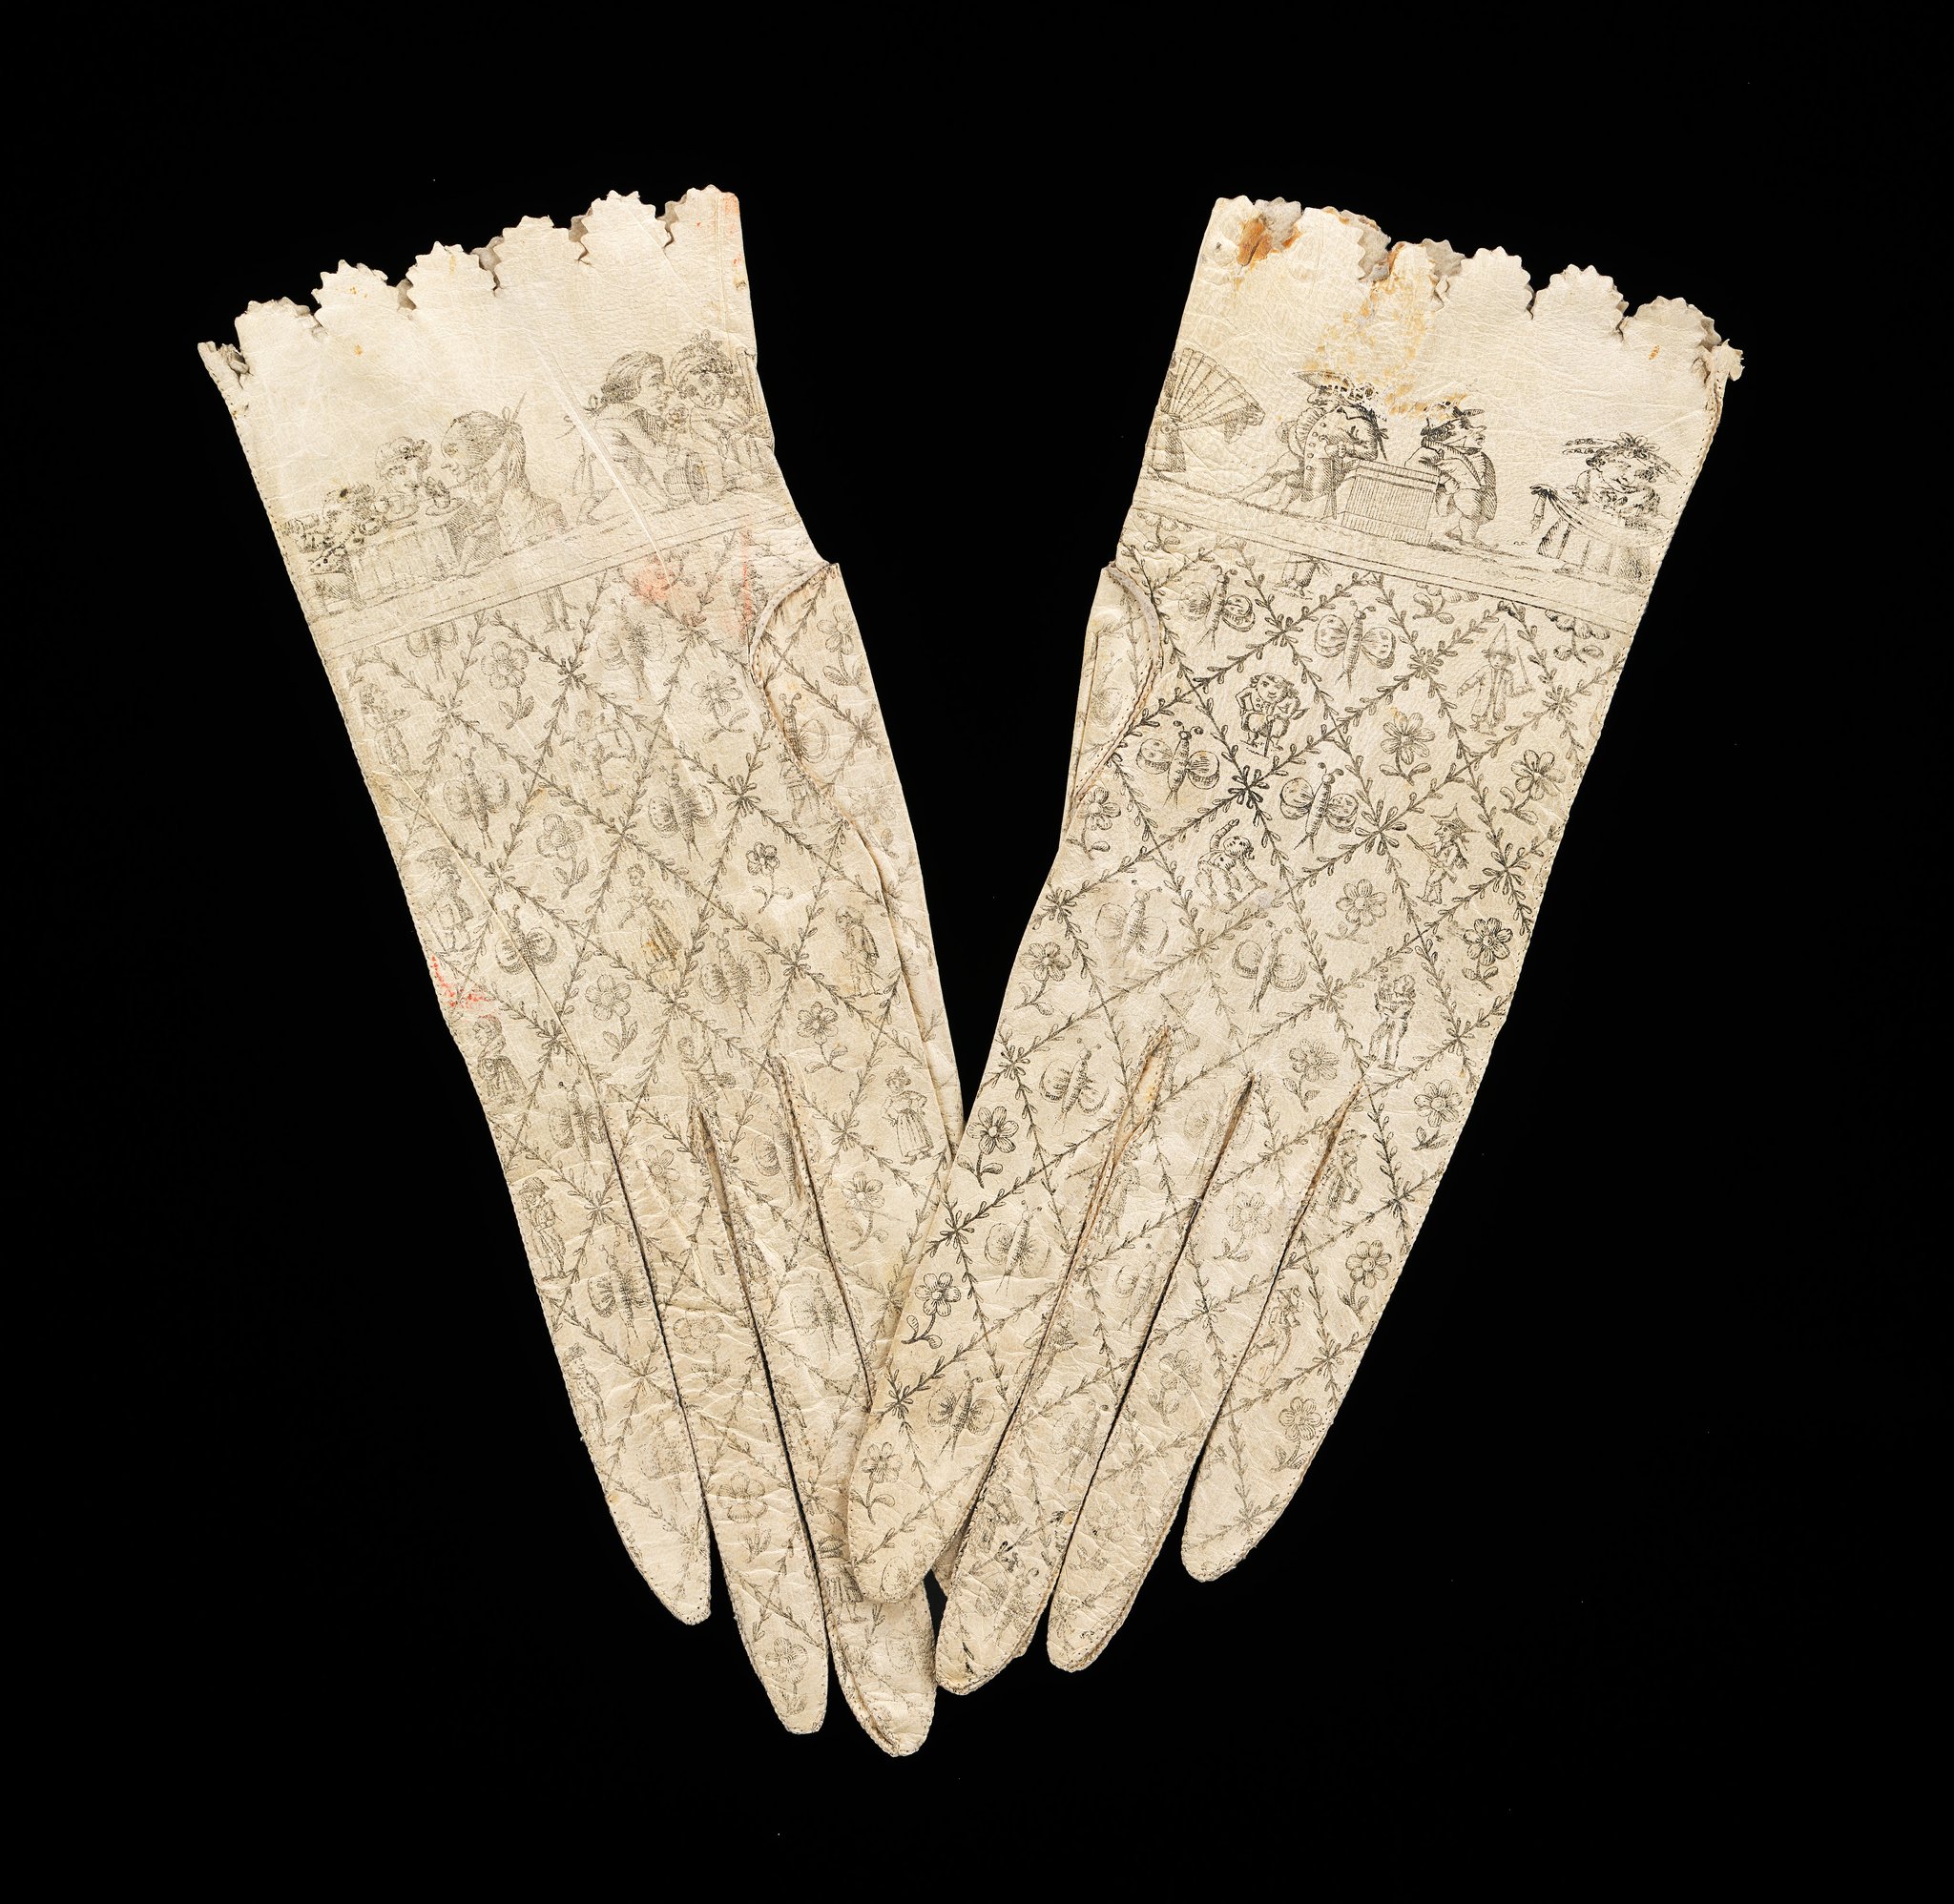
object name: glove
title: Gloves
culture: spanish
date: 1800-1810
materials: leather